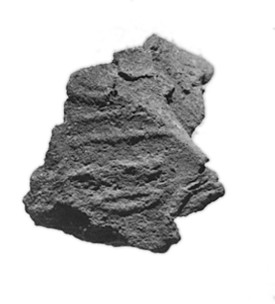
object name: sealing, administrative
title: Administrative Seal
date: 1981-1640 BCE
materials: clay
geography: egypt